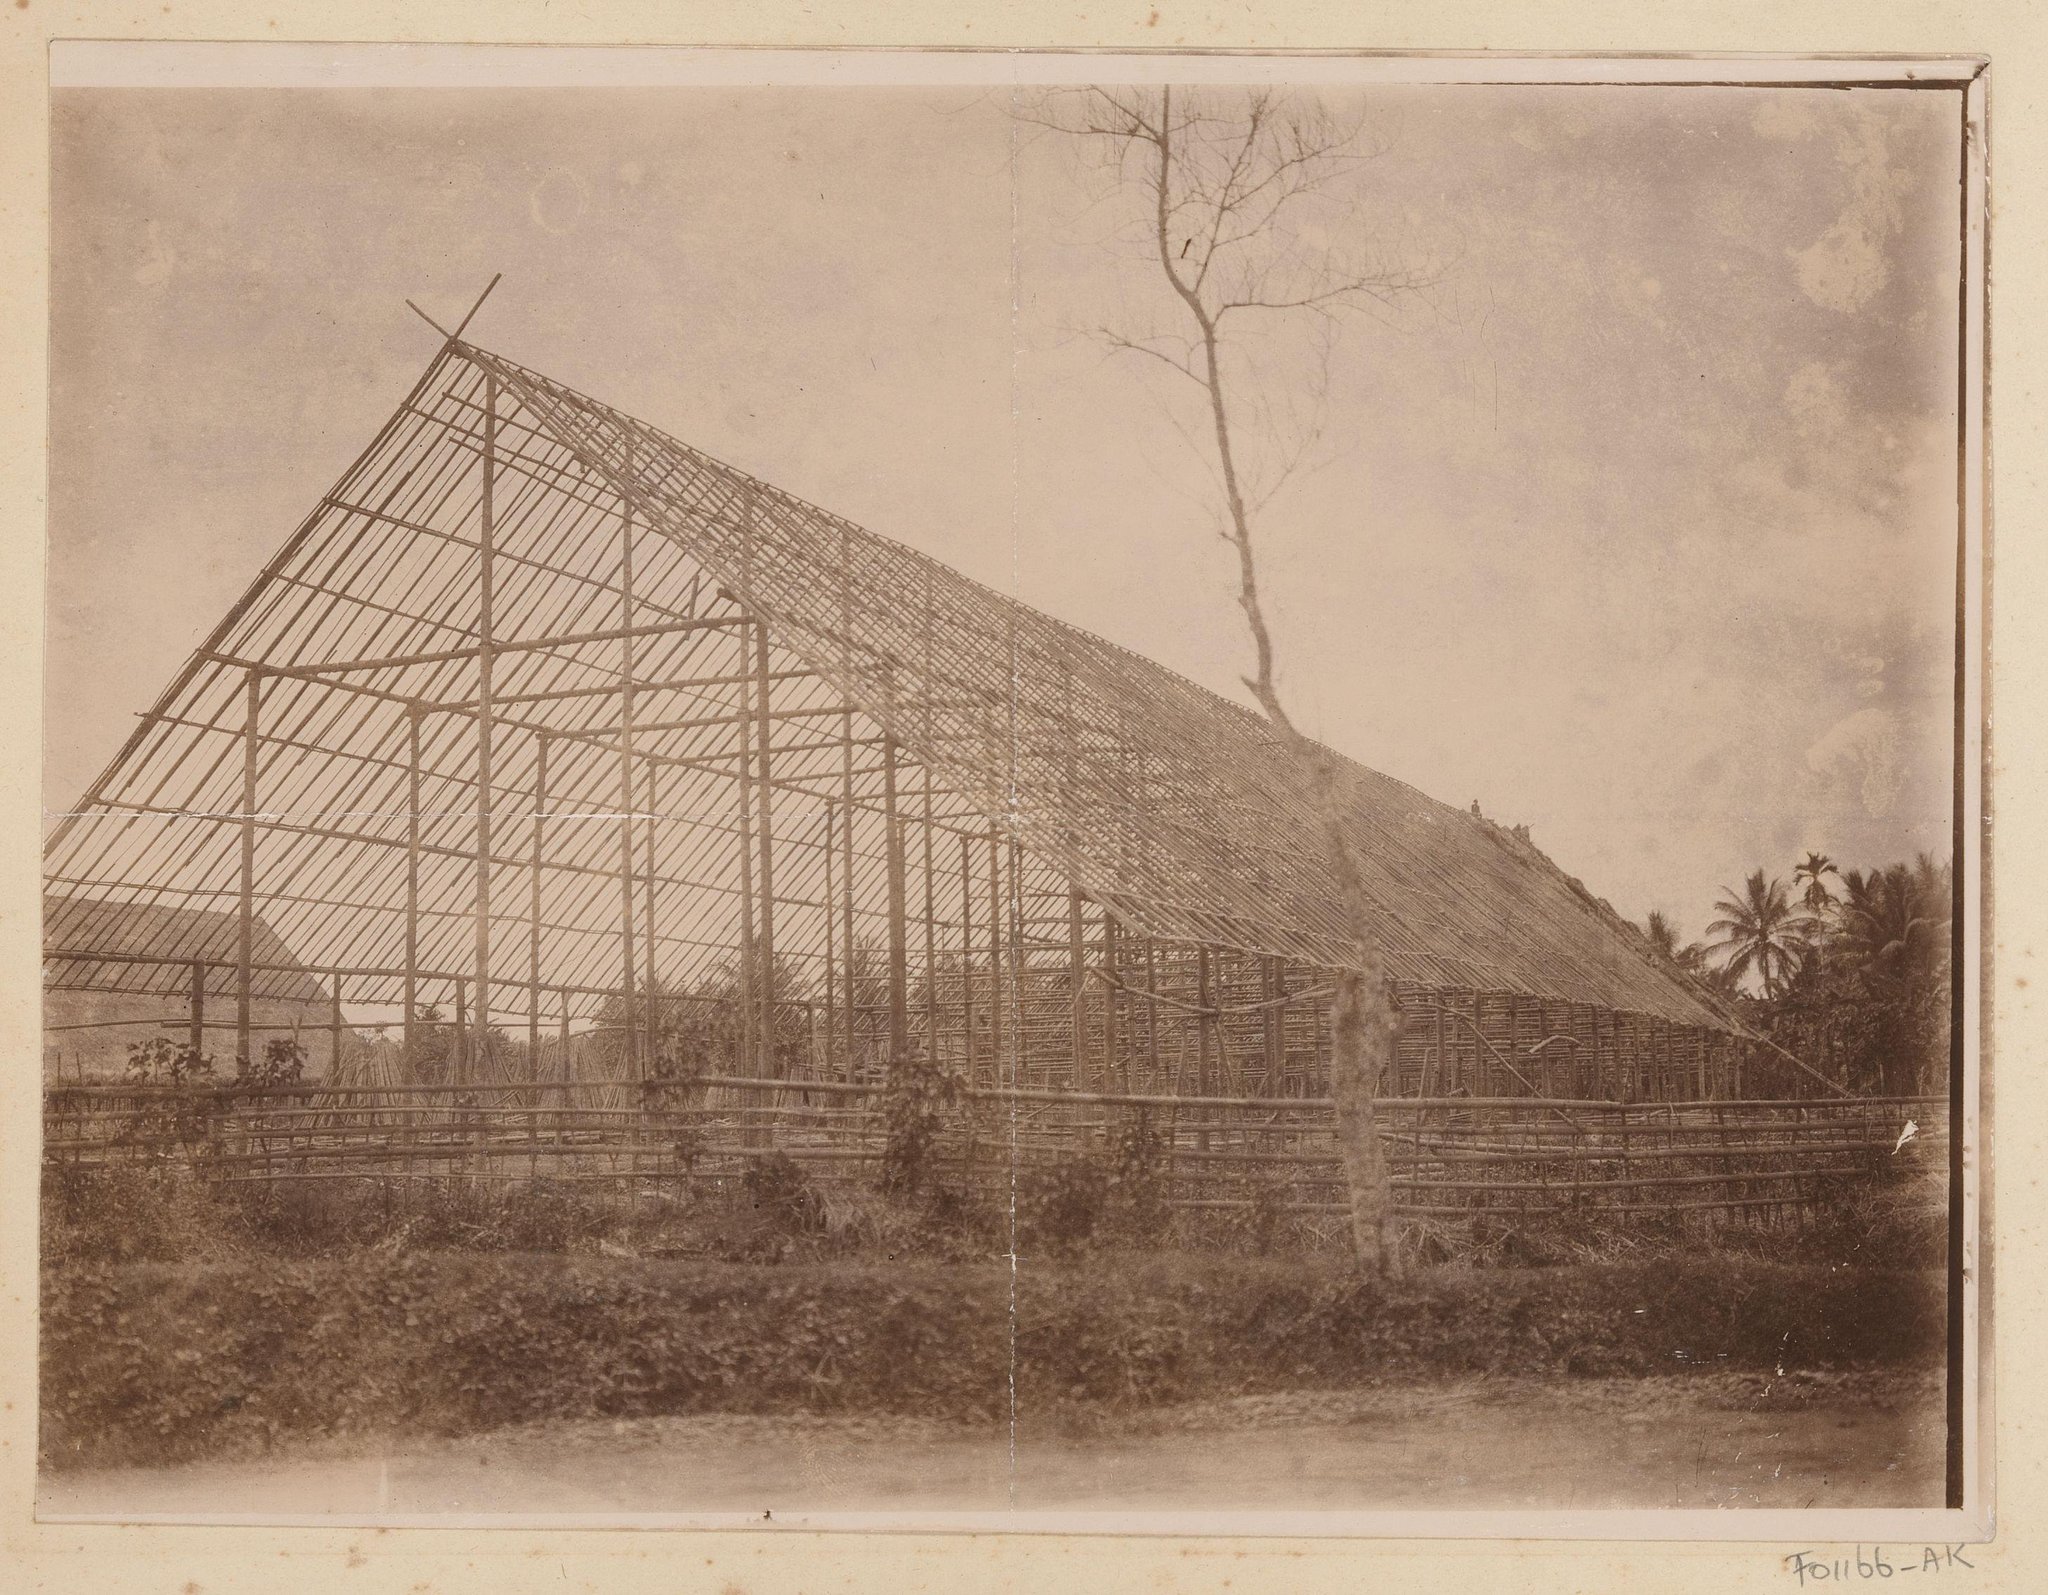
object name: album leaf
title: Skelet van een schuur in aanbouw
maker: Anonymous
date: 1890-1910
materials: photographic support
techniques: collodion silver print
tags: annexes and outbuildings; fencing; gate, building activities, dutch east indies, the